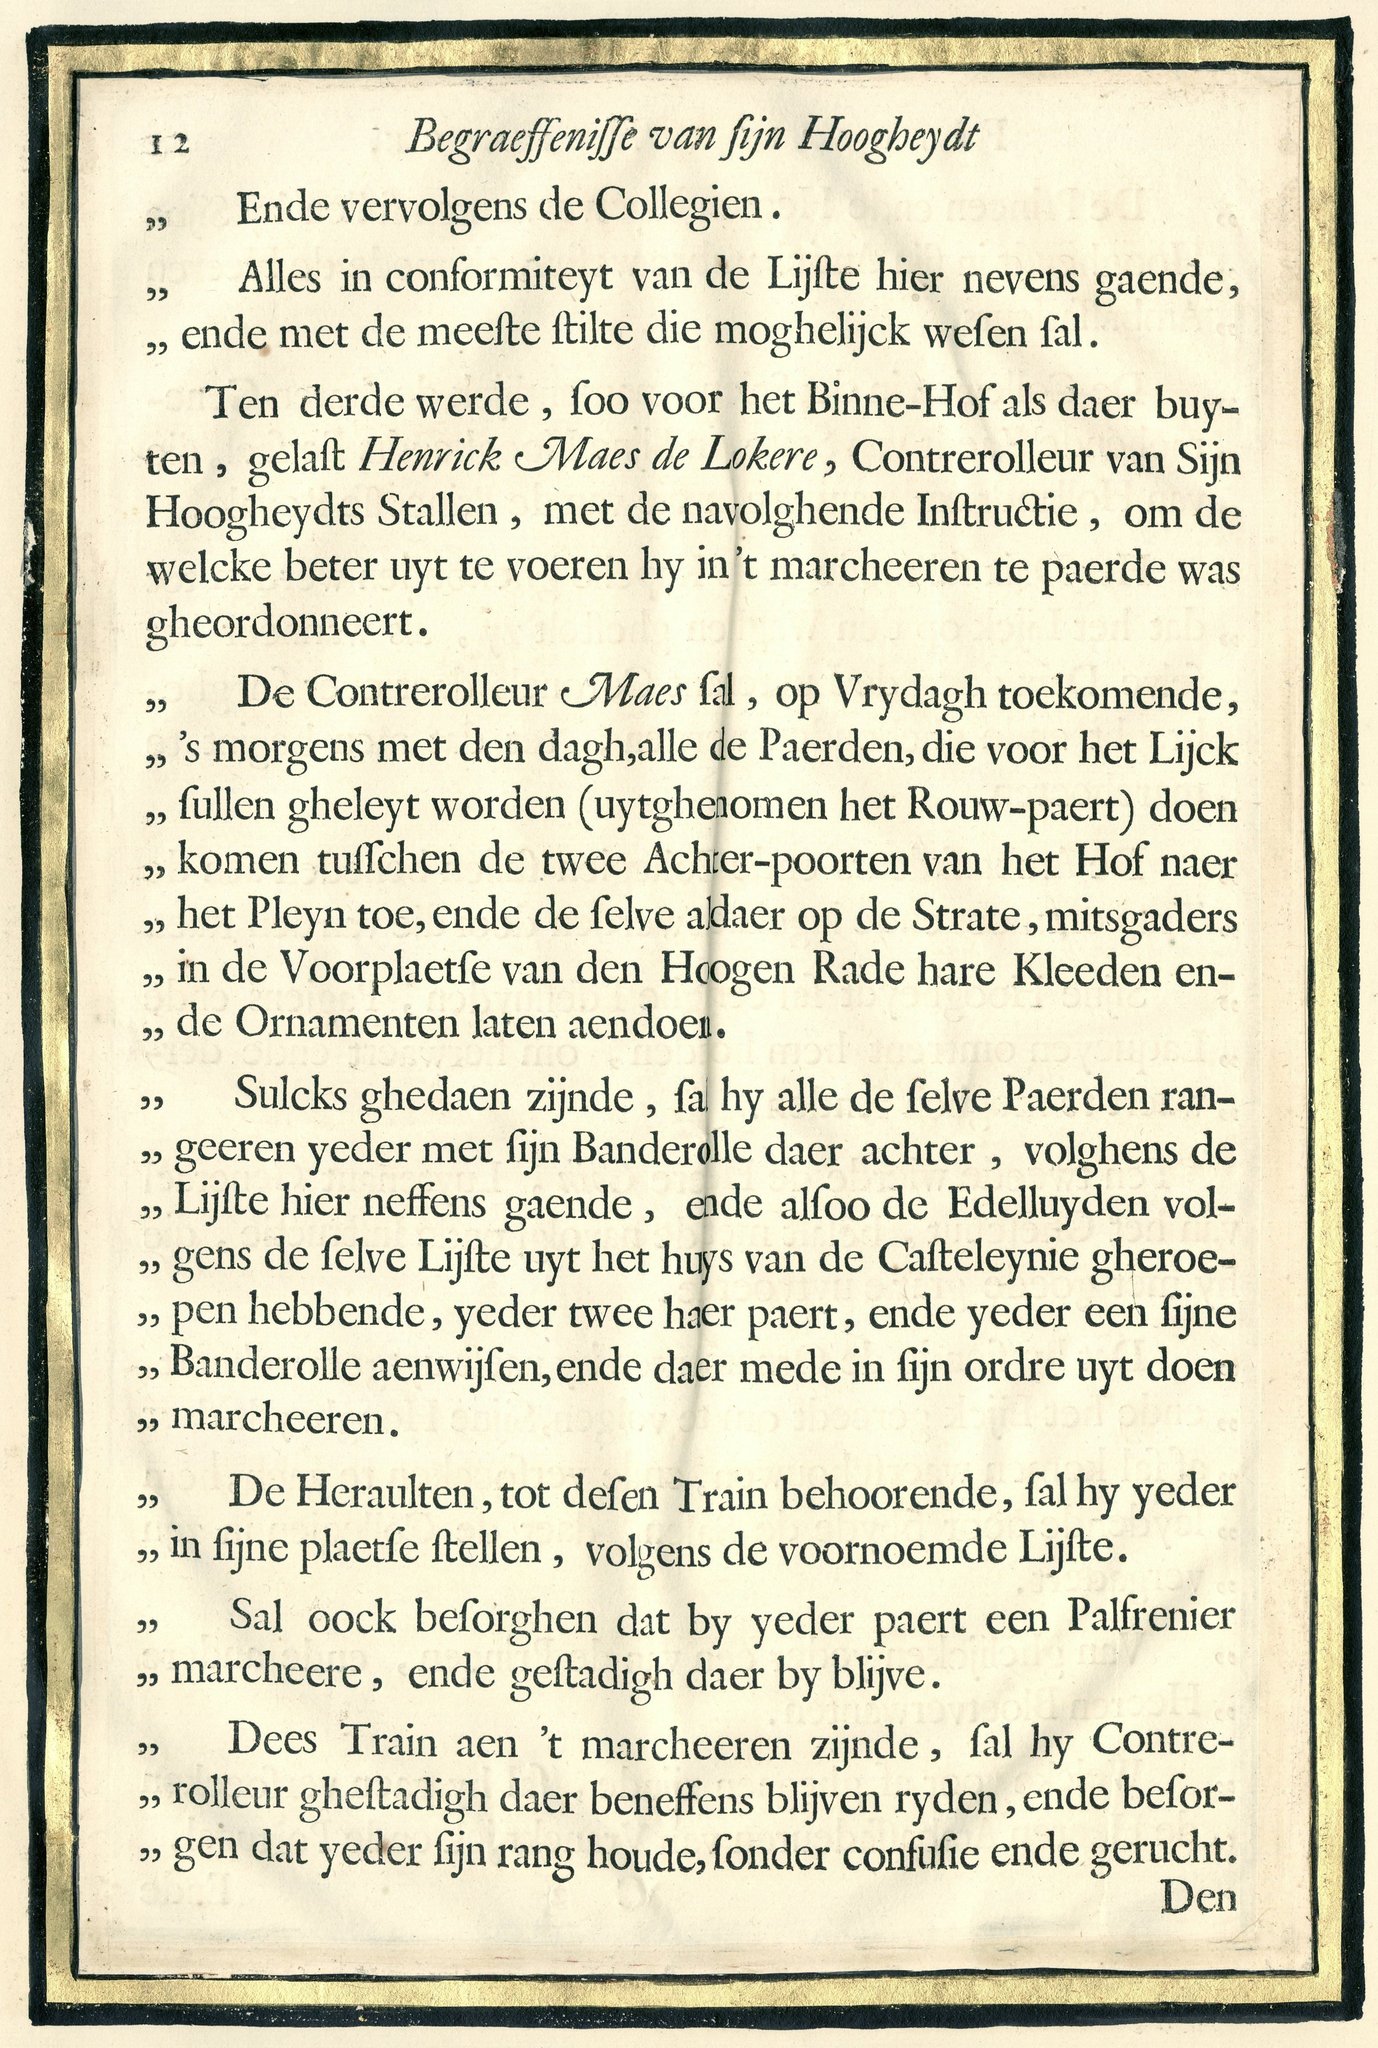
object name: book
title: De beschrijving van de begrafenis van Frederik Hendrik, p. 12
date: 1651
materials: paint, paper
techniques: letterpress printing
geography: amsterdam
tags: delft, frederick henry (prince of orange)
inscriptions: date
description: Pagina12 van de beschrijving van de begrafenis van Frederik Hendrik. Blad uitgeknipt, versierd met goud en ingeplakt in de luxe editie uit ca. 1755 van het boek 'Begraeffenisse van syne hoogheyt Frederick Henrick' van Pieter Post, uitgegeven te Amsterdam in 1651.